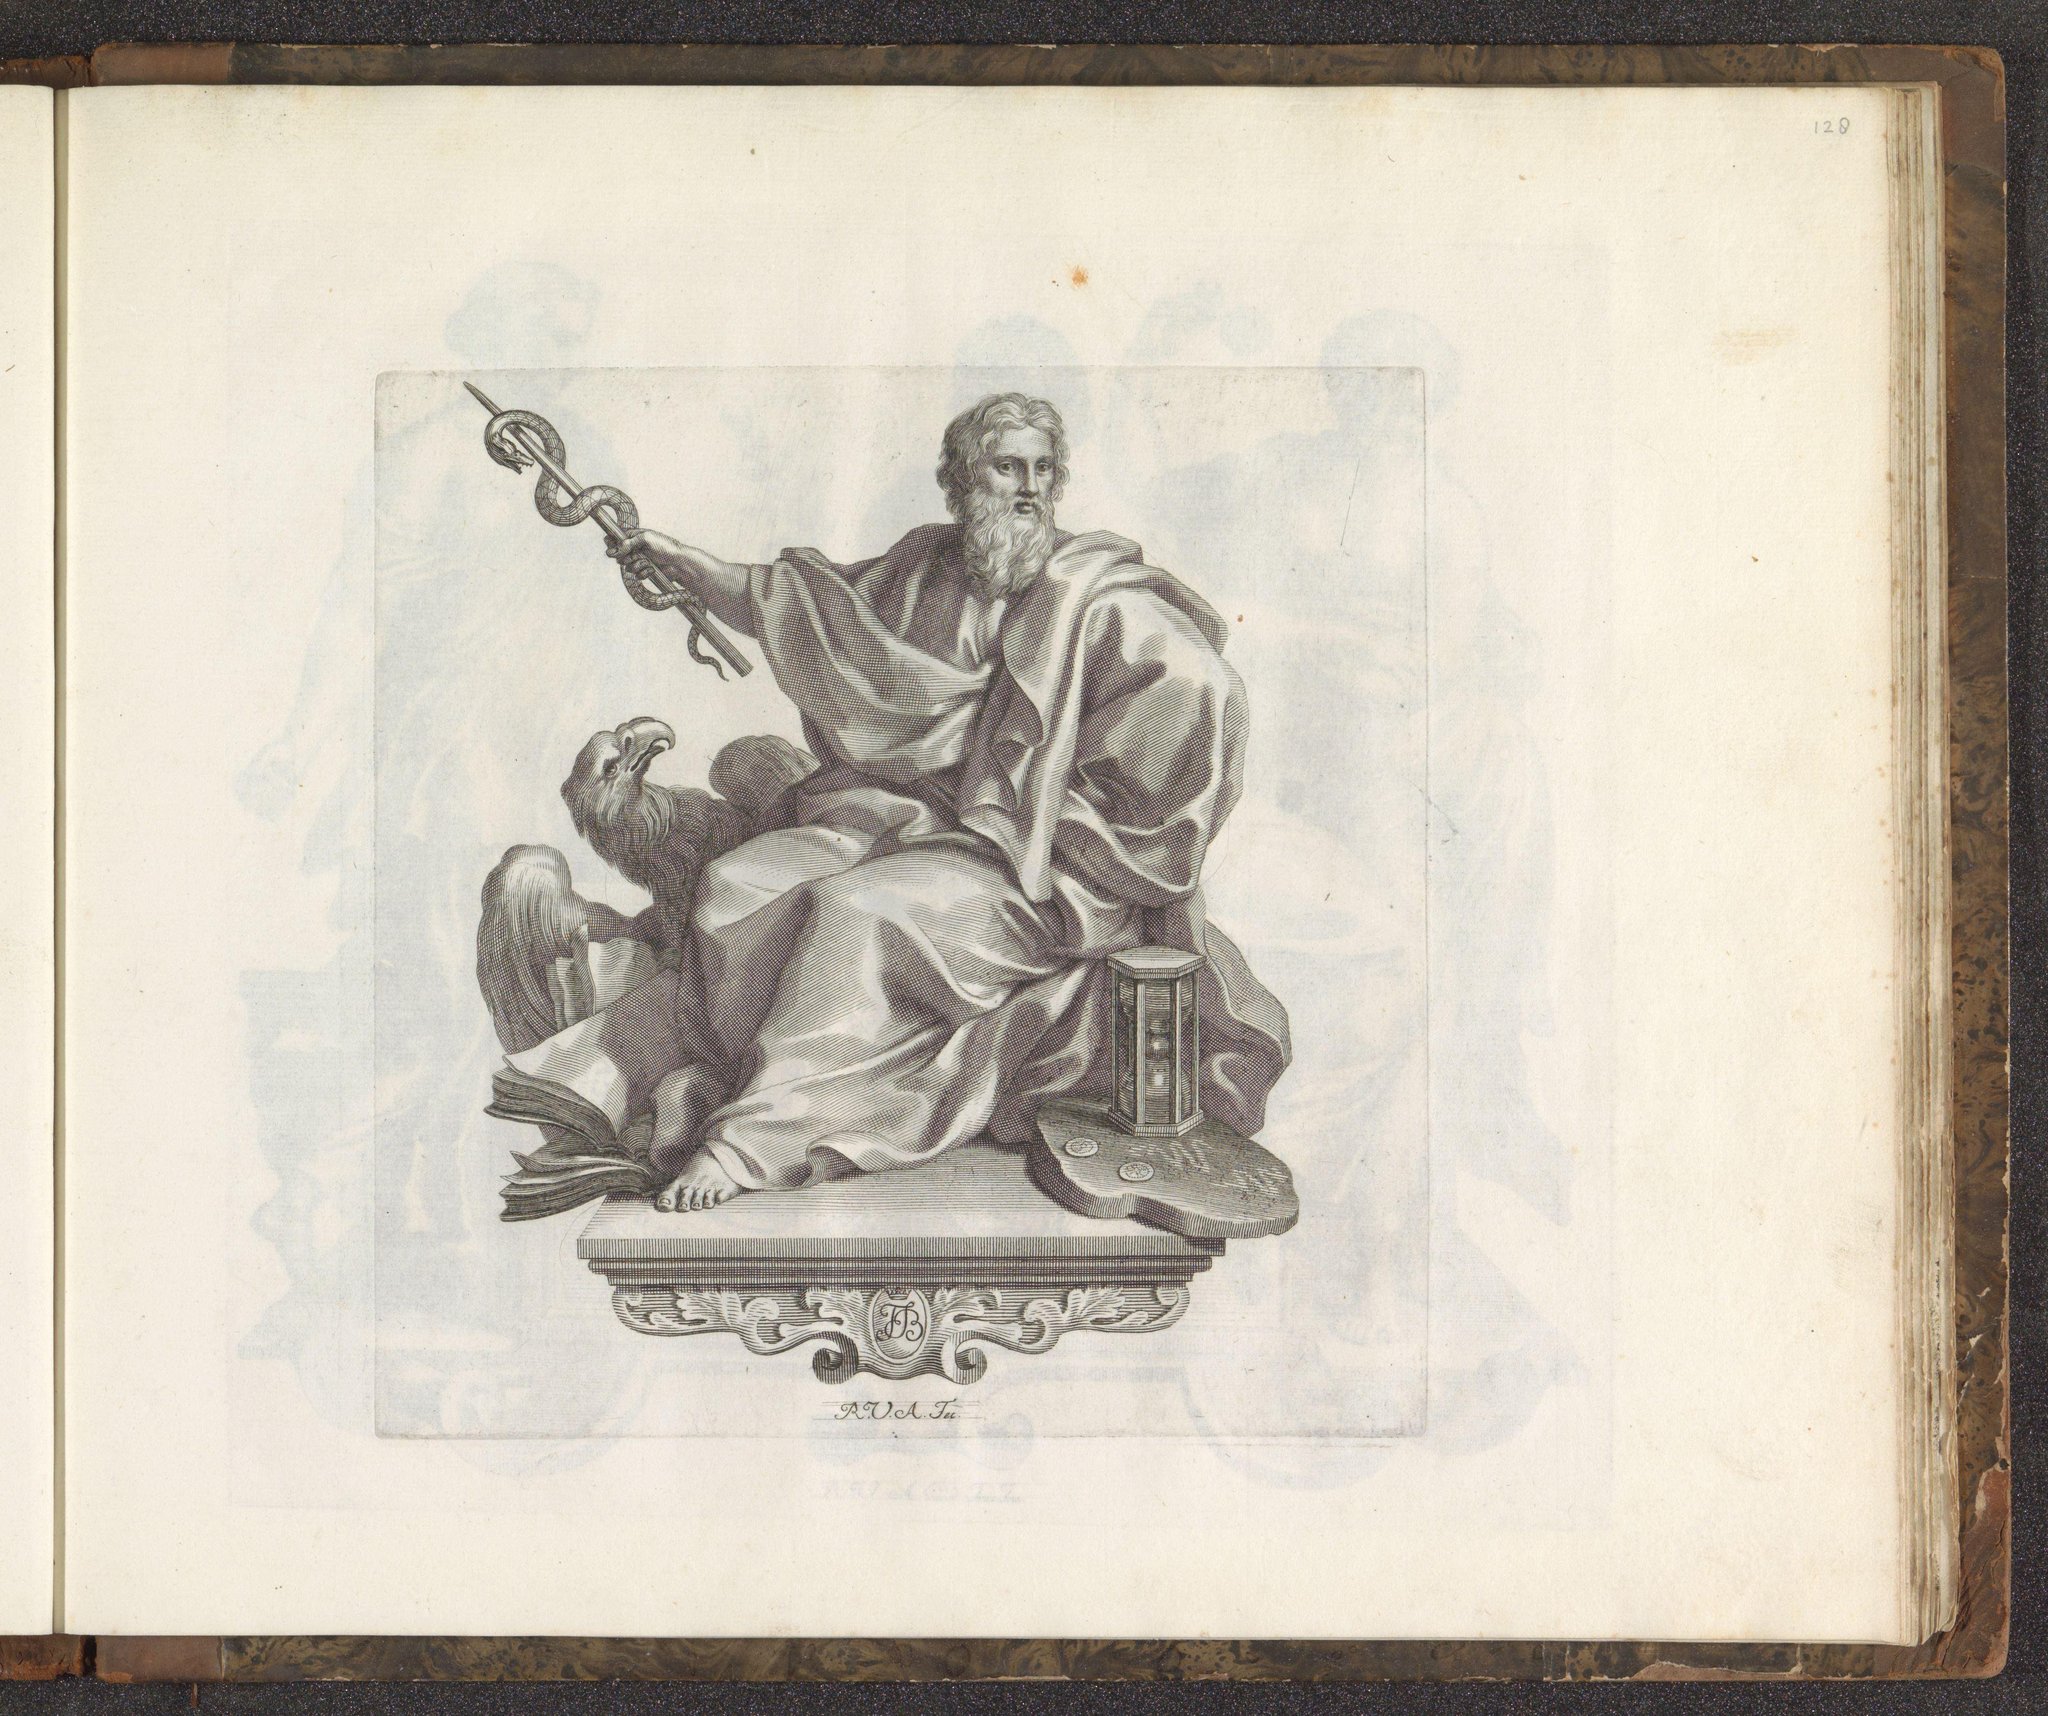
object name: album leaf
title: Personicatie van een Rechter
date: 1673-1743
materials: paper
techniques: engraving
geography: rome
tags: snakes, predatory birds: eagle, 'giudice' (ripa), tools, implements of craftsman: touch-stone, hourglass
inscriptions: collector's mark: Lugt 2228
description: Een console met de personificatie van een rechter. Het betreft een zittende oude man met in zijn rechterhand een roede met een slang. Links naast hem een adelaar en een opengeslagen boek. Rechts staat een zandloper op een toetssteen waarop met enkele munten gestreken is. De prent maakt deel uit van een album.